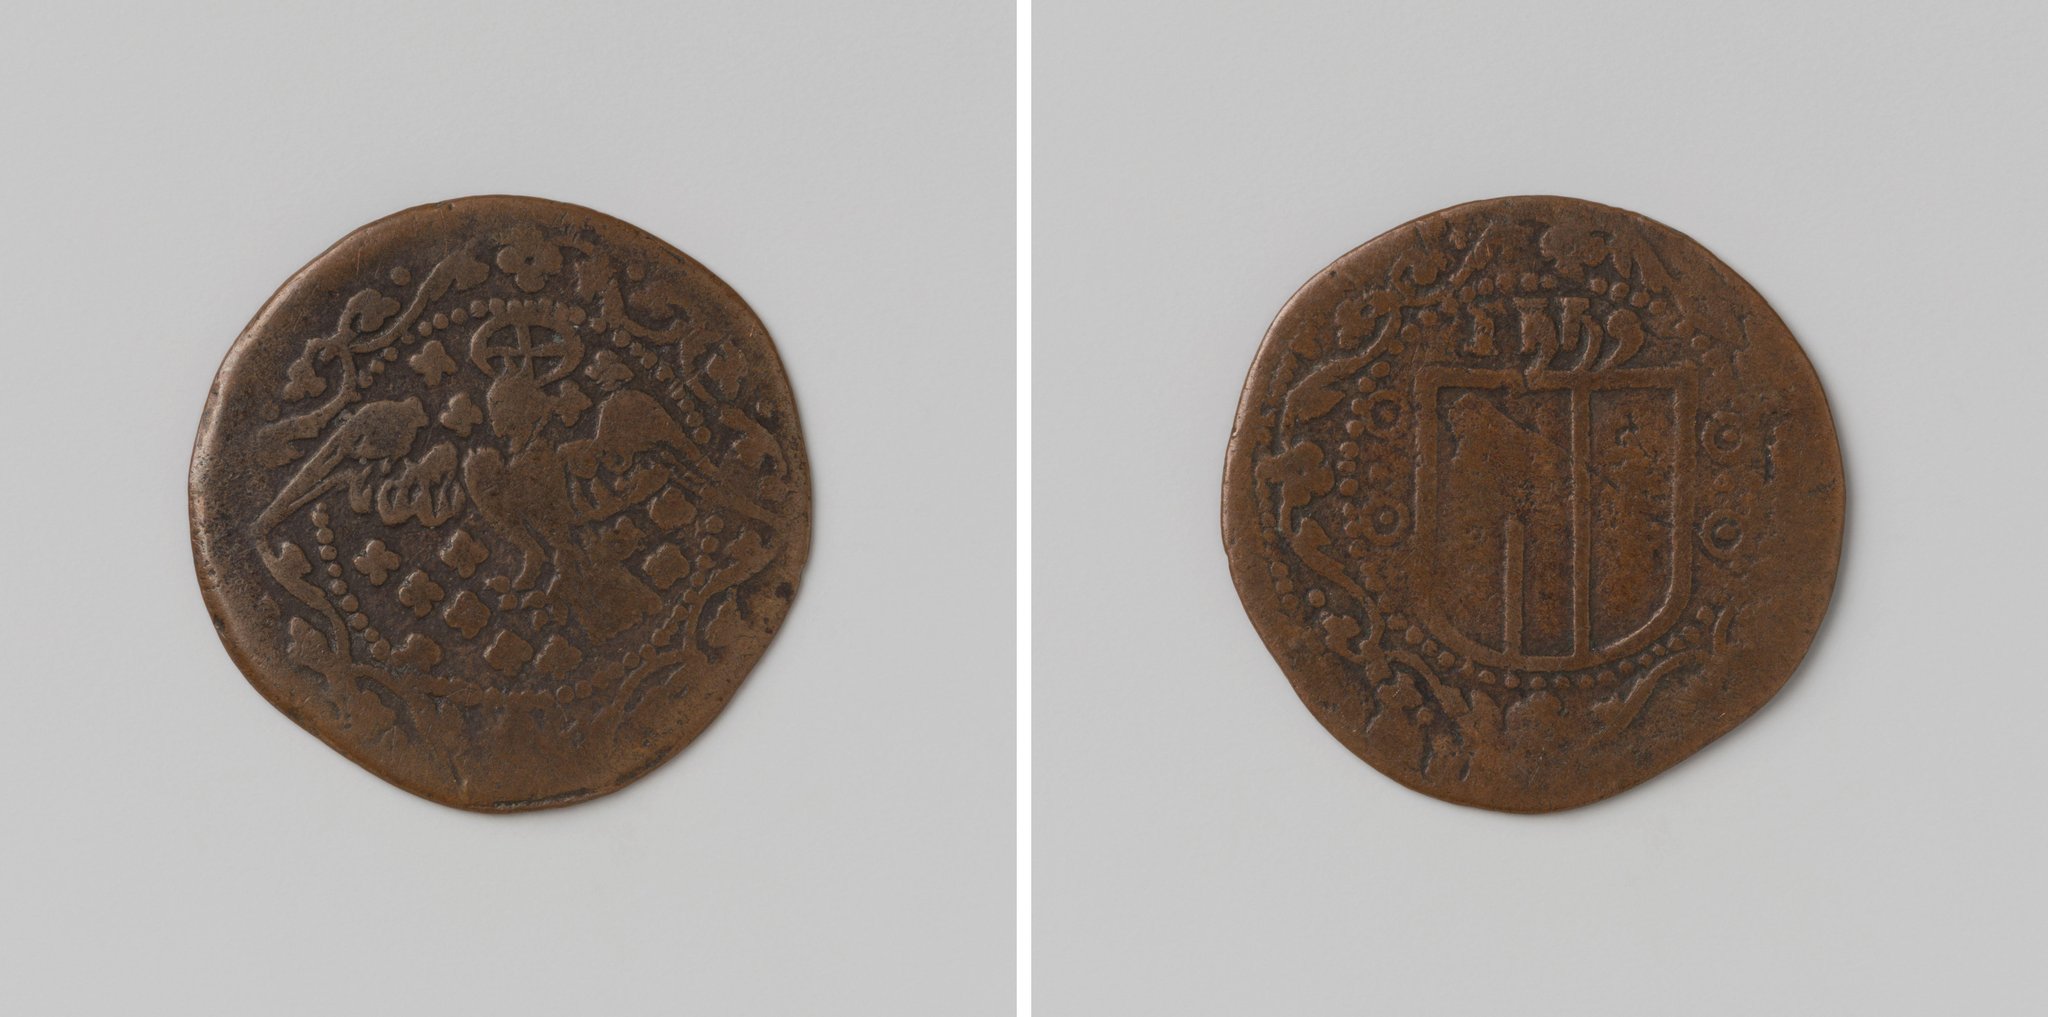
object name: coin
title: Steunoordje, Heilige Geest- of weeshuis van Gouda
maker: Anonymous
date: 1559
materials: copper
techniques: striking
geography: gouda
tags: gouda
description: Voorzijde: duif met gespreide vleugels en aureool temidden van sterren binnen sierrand. Keerzijde: wapenschild onder jaartal binnen sierrand.